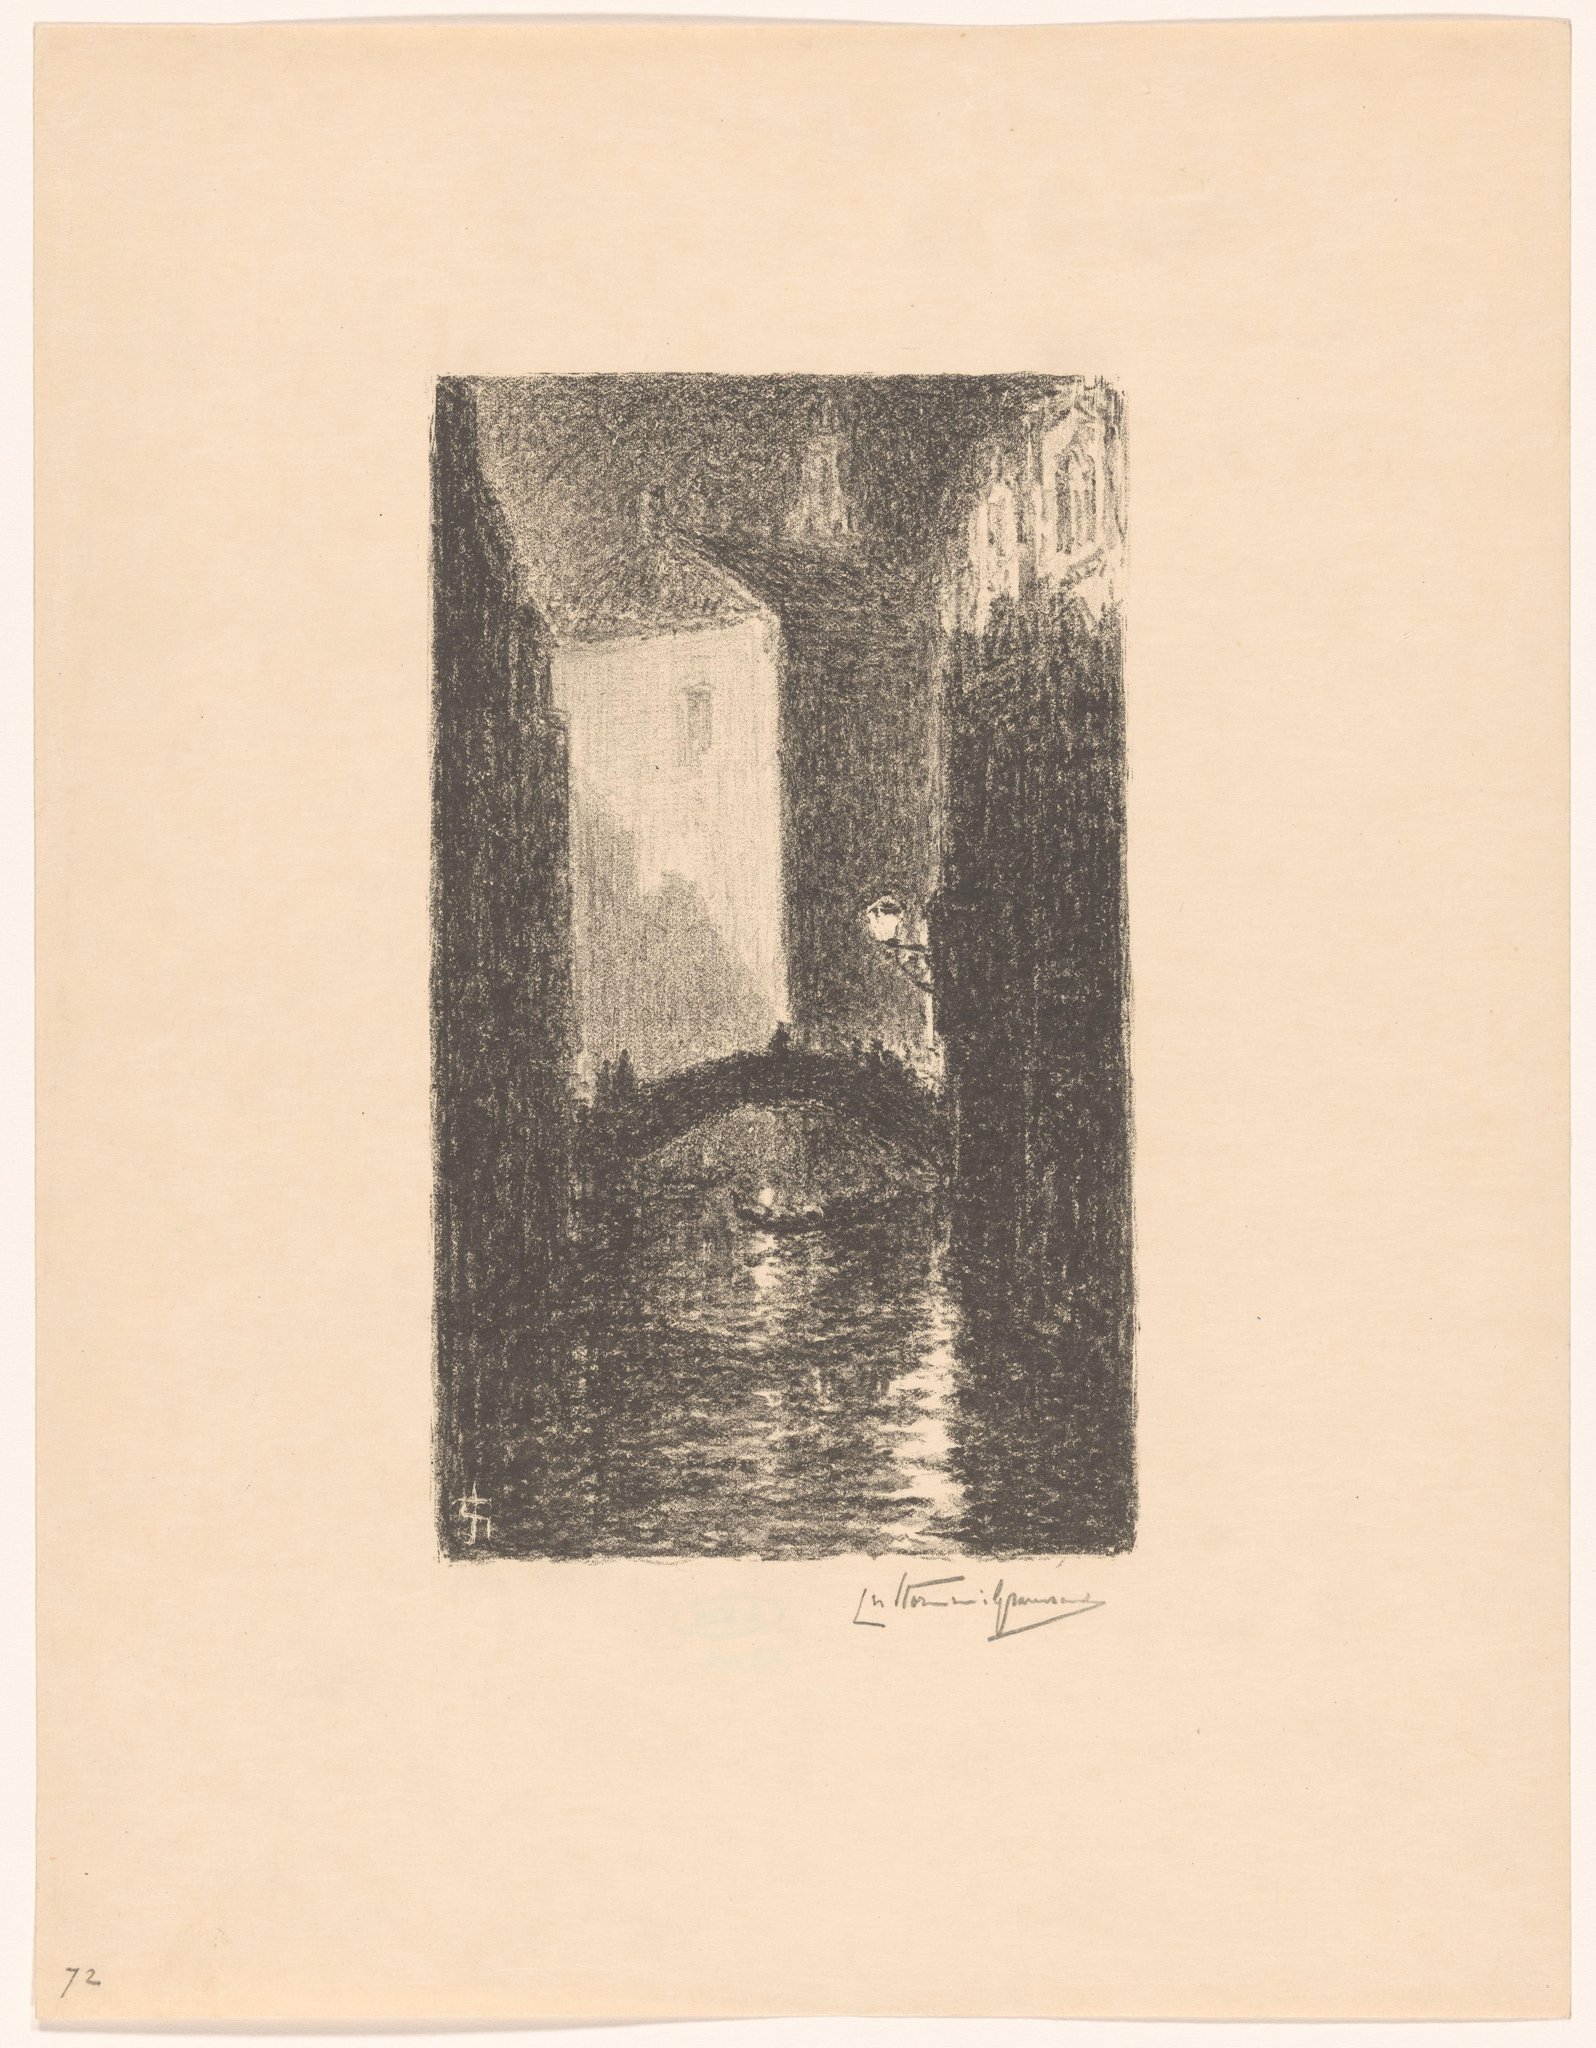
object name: print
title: Brug in Venetië bij avond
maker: carel nicolaas storm van s-gravesande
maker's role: draughtsman, print maker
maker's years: 1841-1924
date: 1851-1924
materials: paper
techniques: lithograph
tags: bridge in city across river, canal, etc. (+ city(-scape) with figures, staffage), evening, venice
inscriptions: number: ‘72’, collector's mark: Lugt 2228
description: Mogelijk vermeld in: Storm van 's-Gravesande, Charles. Catalogue des eaux-fortes et lithographies. New York: s.n., 1903, of in een onbekende latere uitgave van het manuscript. Vermoedelijk vermeld als catalogusnummer 72.